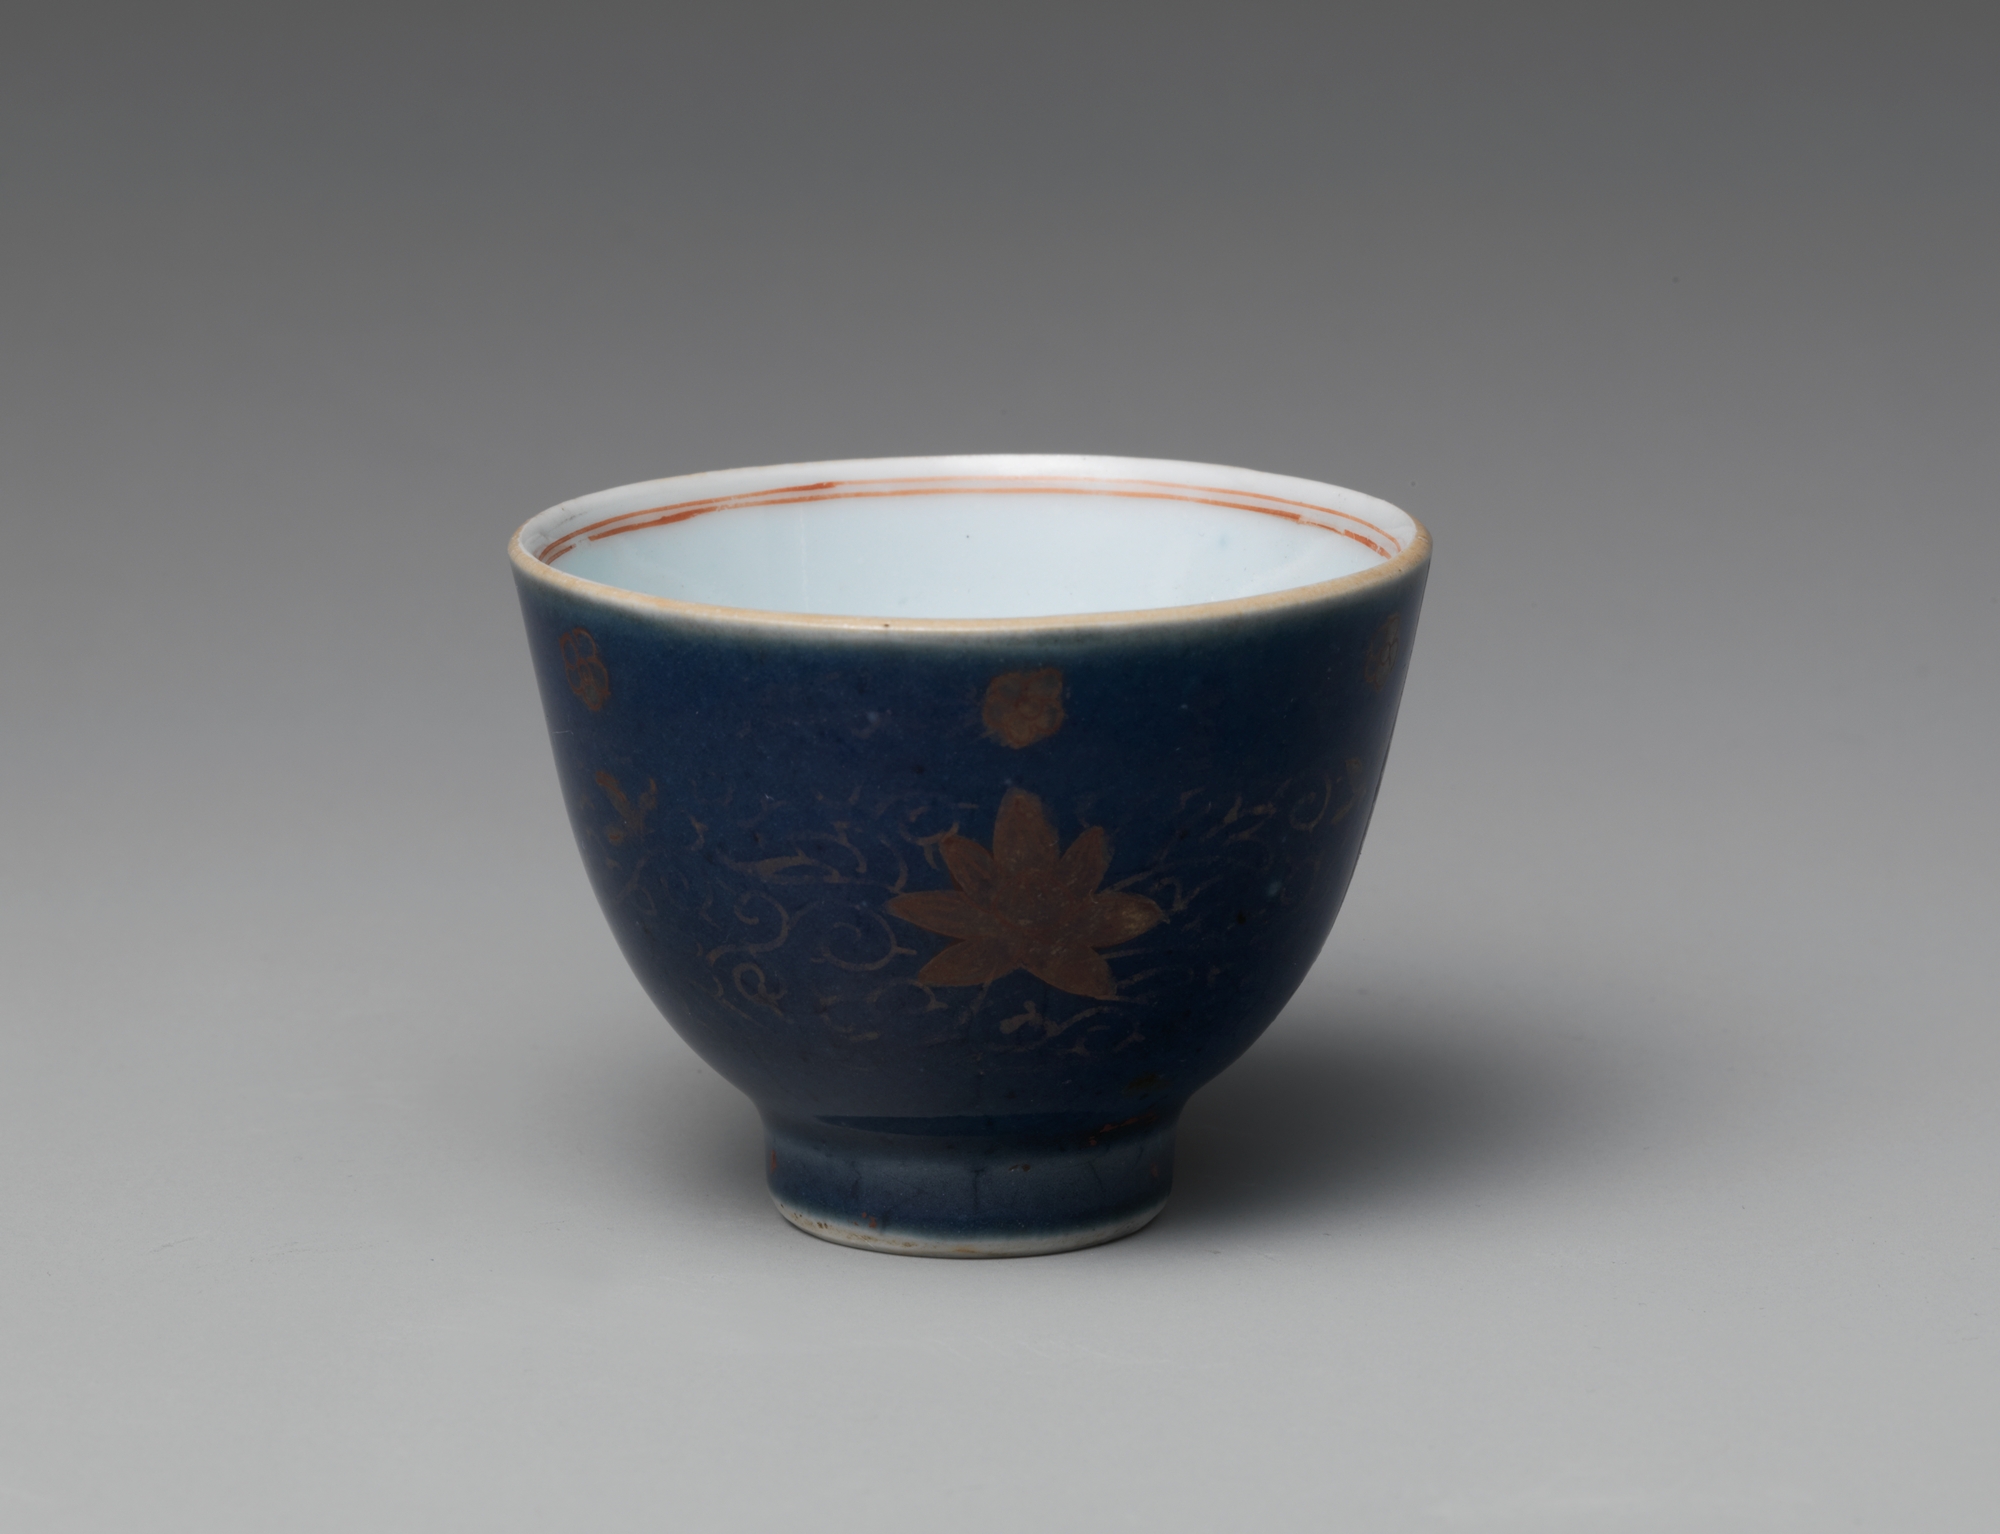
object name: cup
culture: chinese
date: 1736-1795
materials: porcelain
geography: china